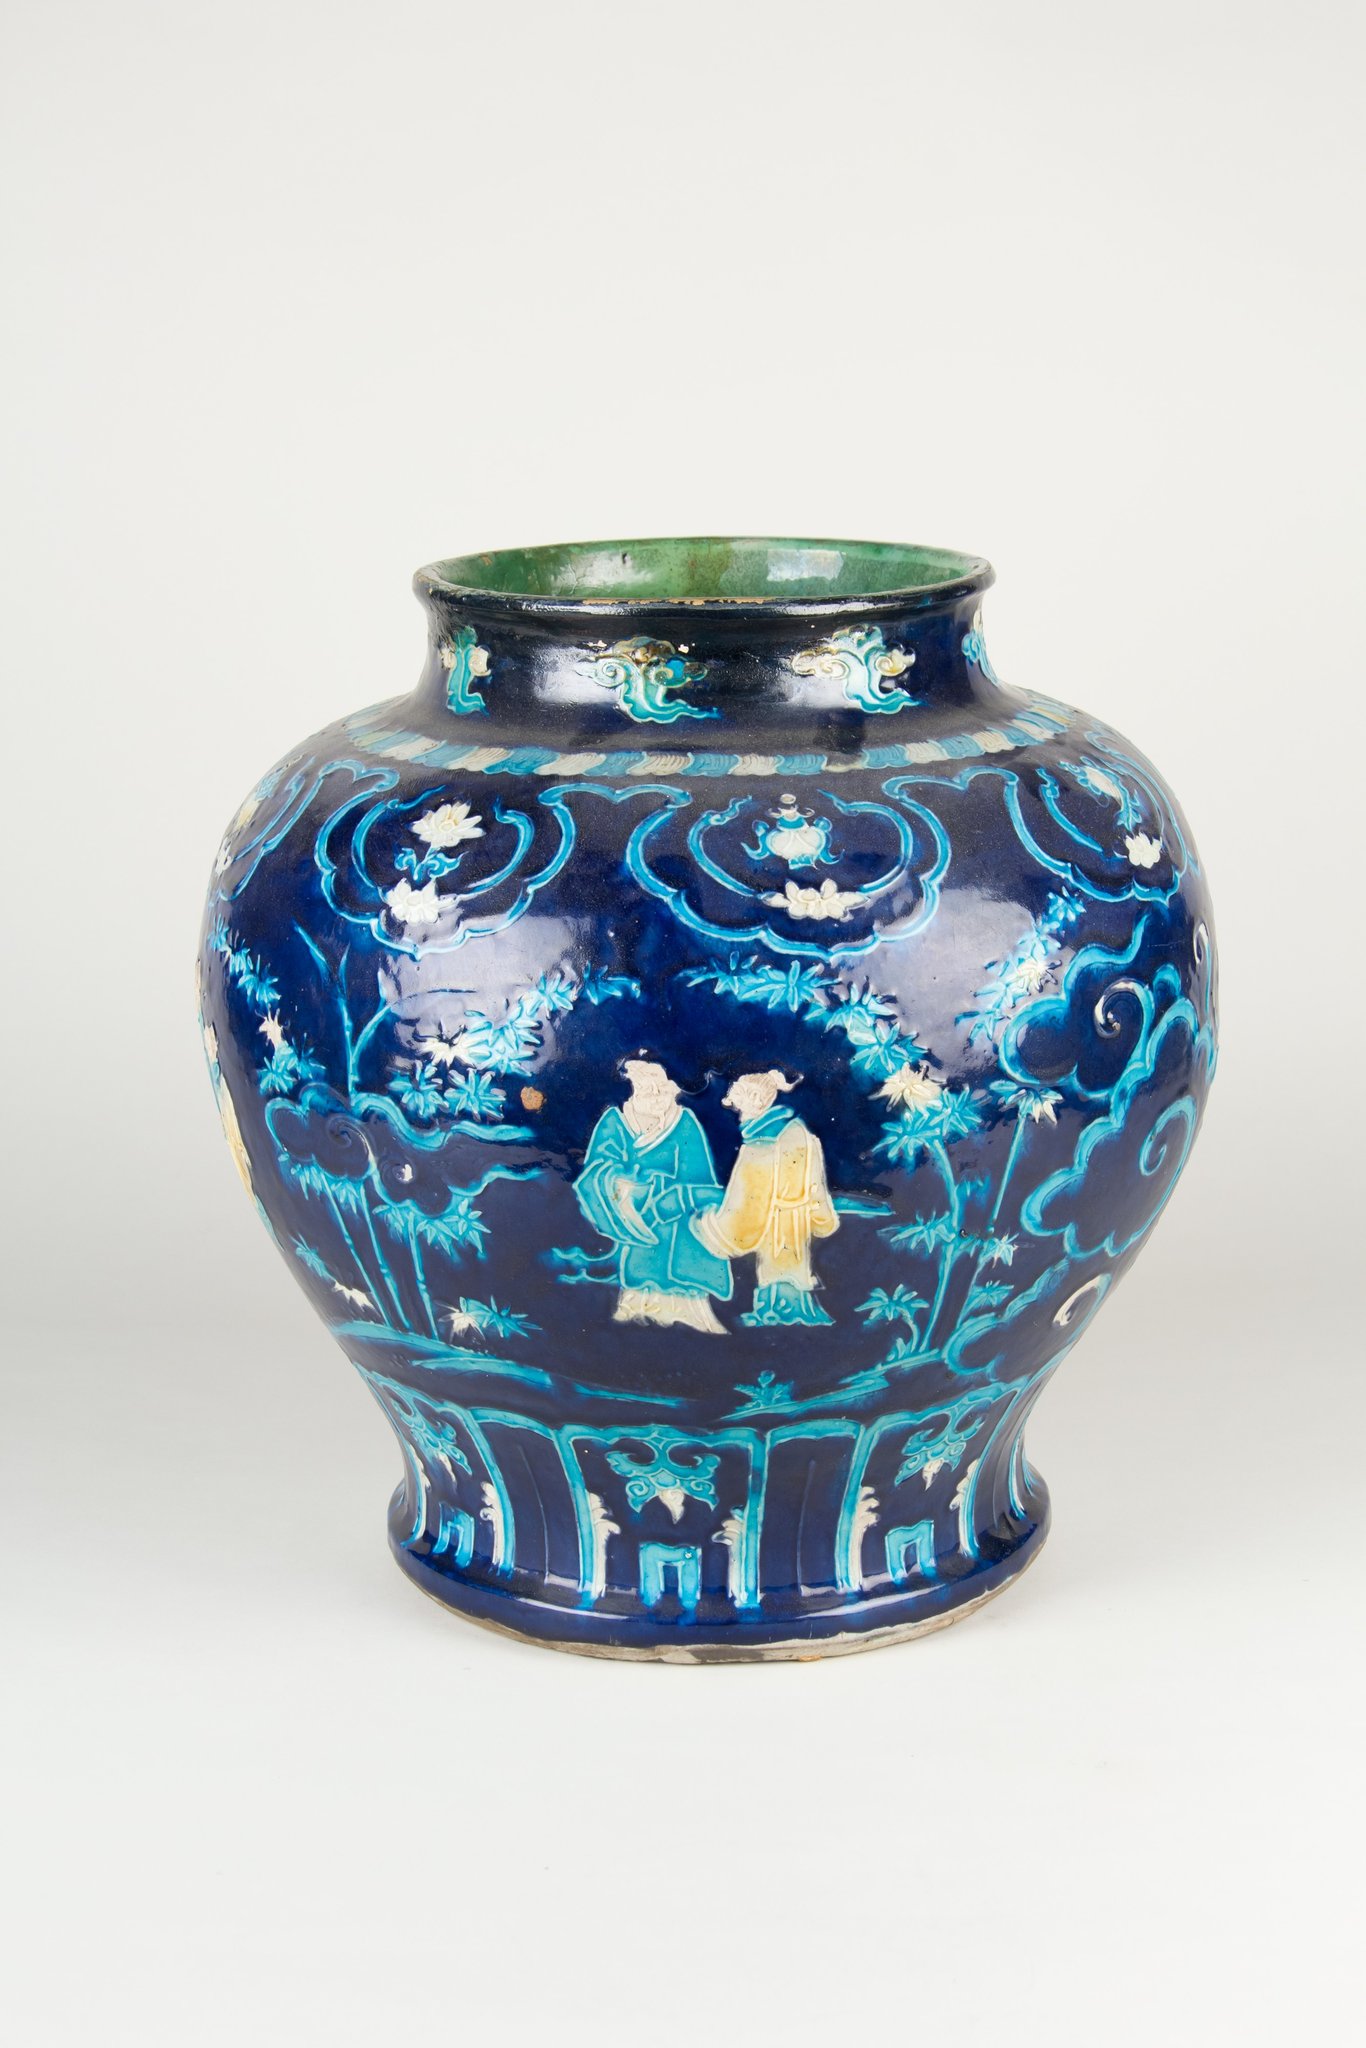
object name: jar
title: Jar with scholars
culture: chinese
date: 1467-1500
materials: enamel, stoneware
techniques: polychrome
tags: human figures,flowers